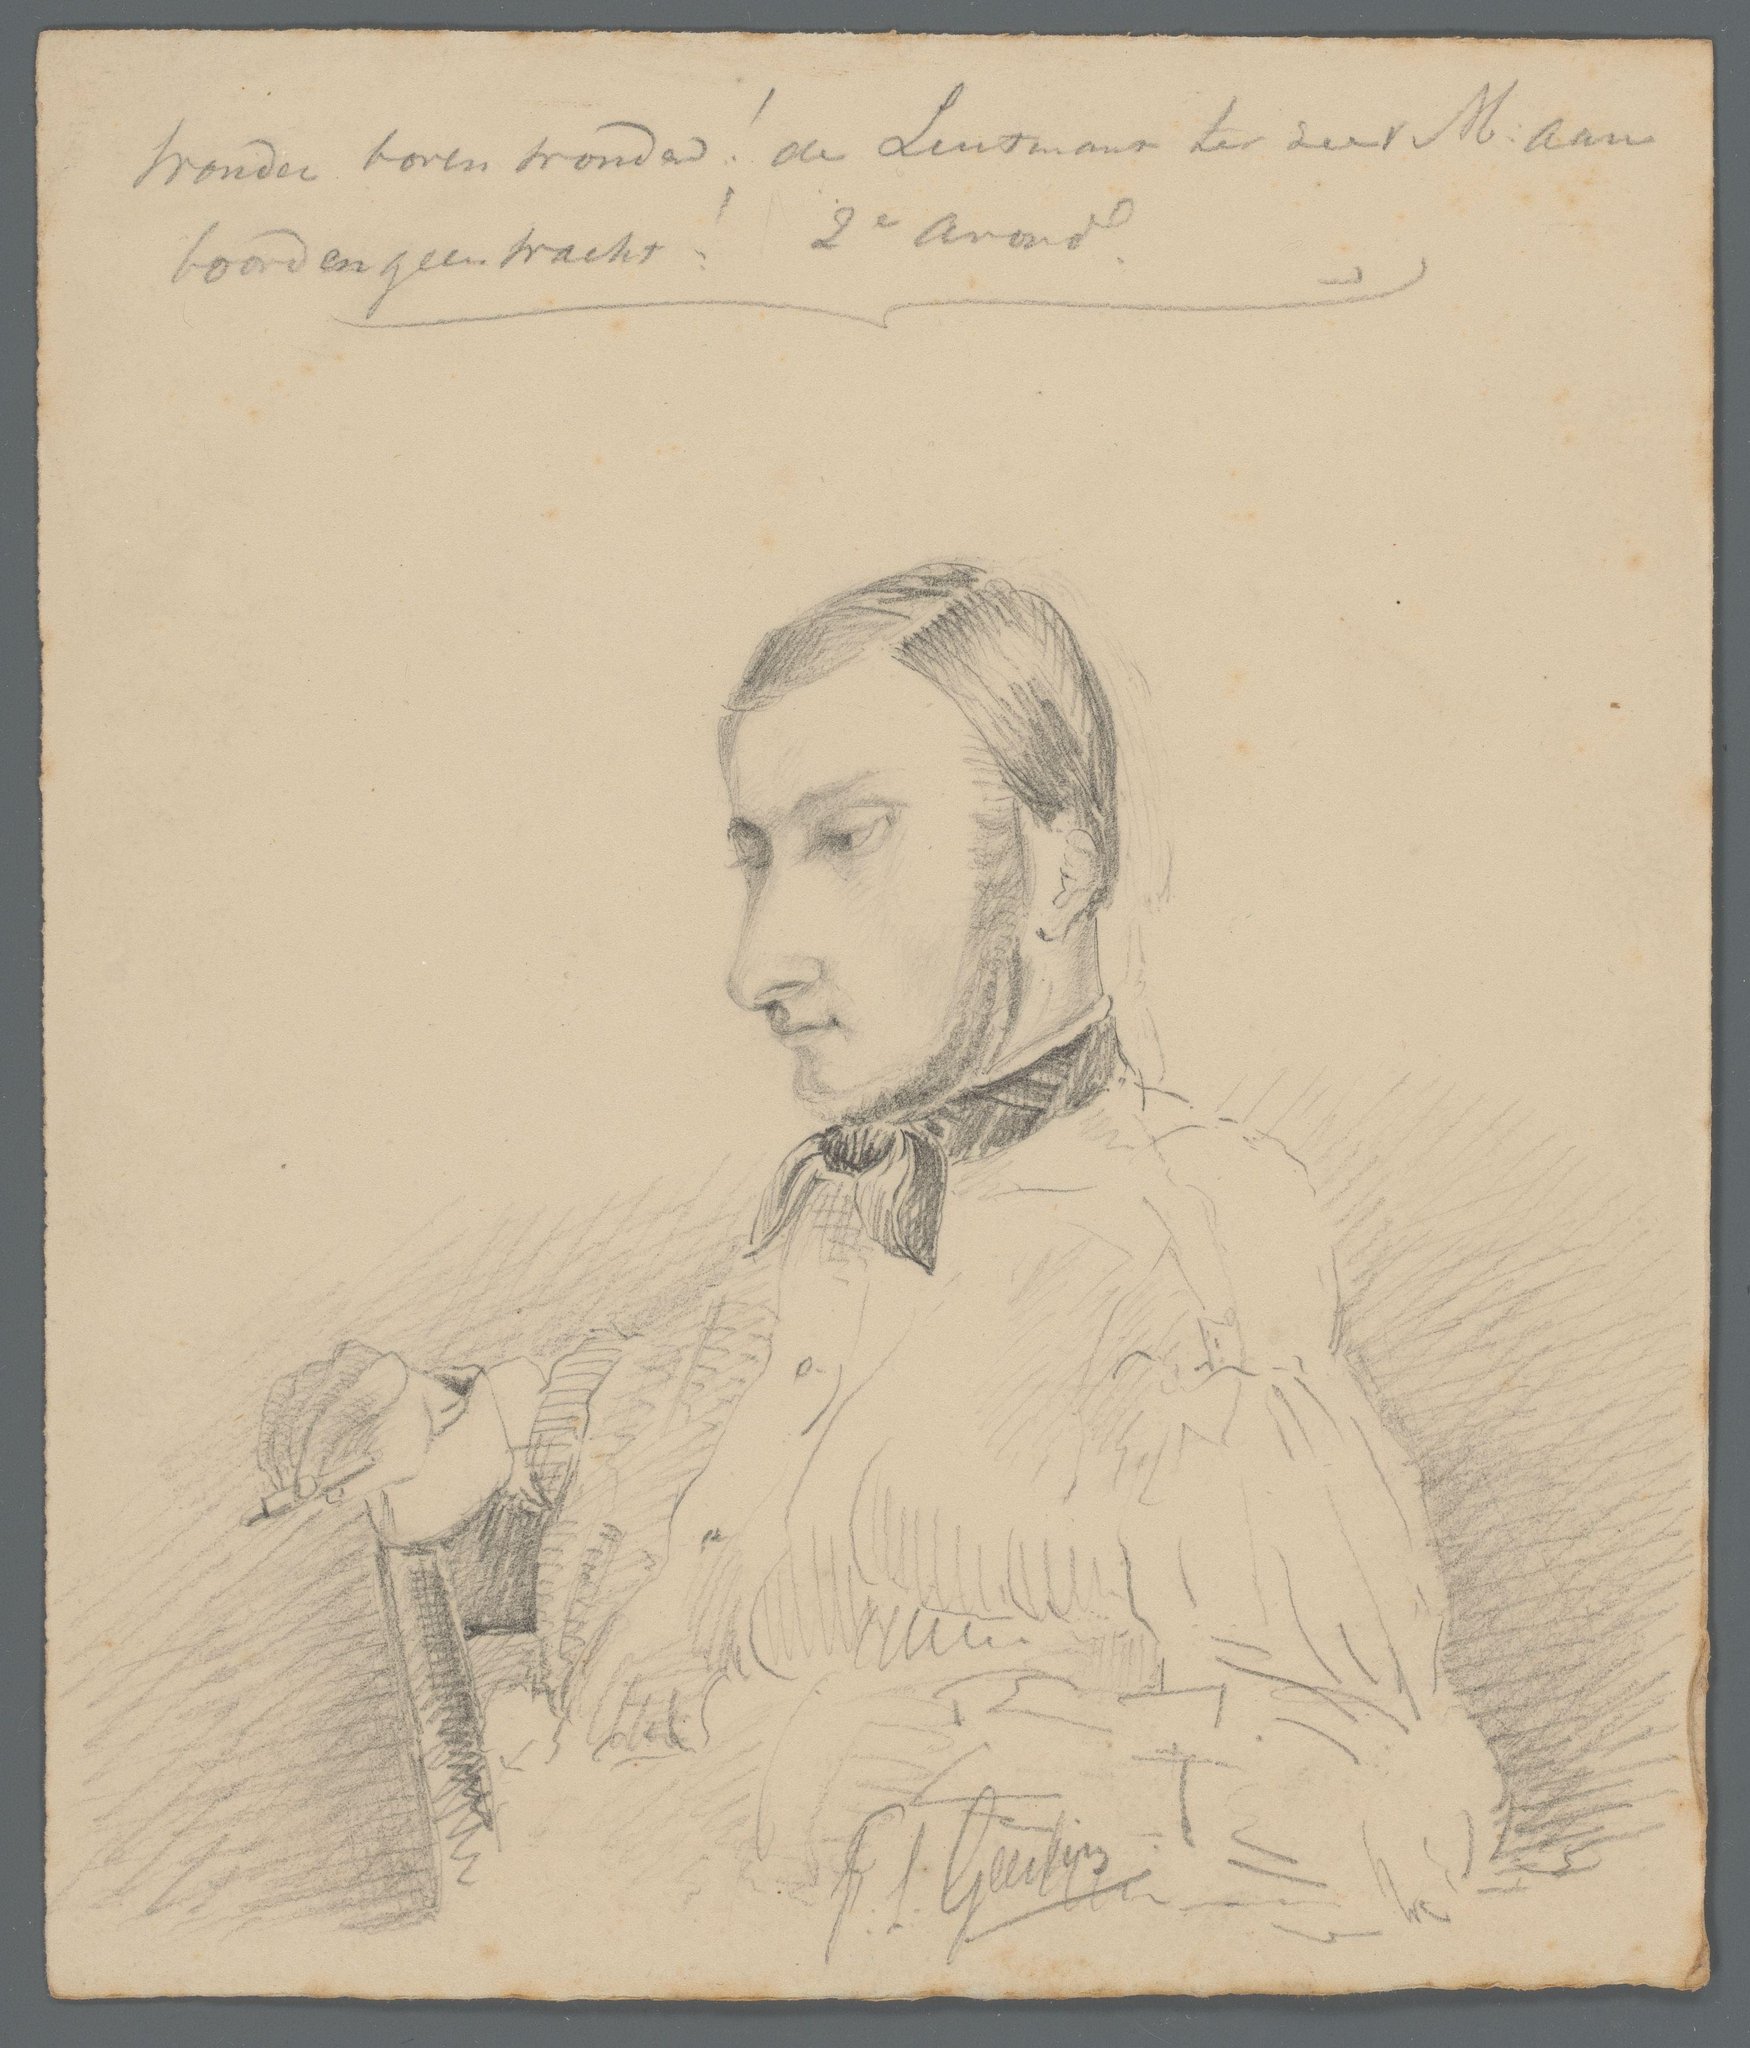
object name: drawing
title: Portret van een marineofficier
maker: frederik lambertus geerling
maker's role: naval officer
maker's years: 1815-1894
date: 1840-1880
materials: paper, pencil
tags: navy, historical persons not known by name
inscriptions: inscription: ‘Wonder boven wonder! de Luitenant ter zee M. aan boord en geen wacht! 2e avond.’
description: Portret van een jonge luitenant-ter-zee, zittend in een stoel. Met opschrift.